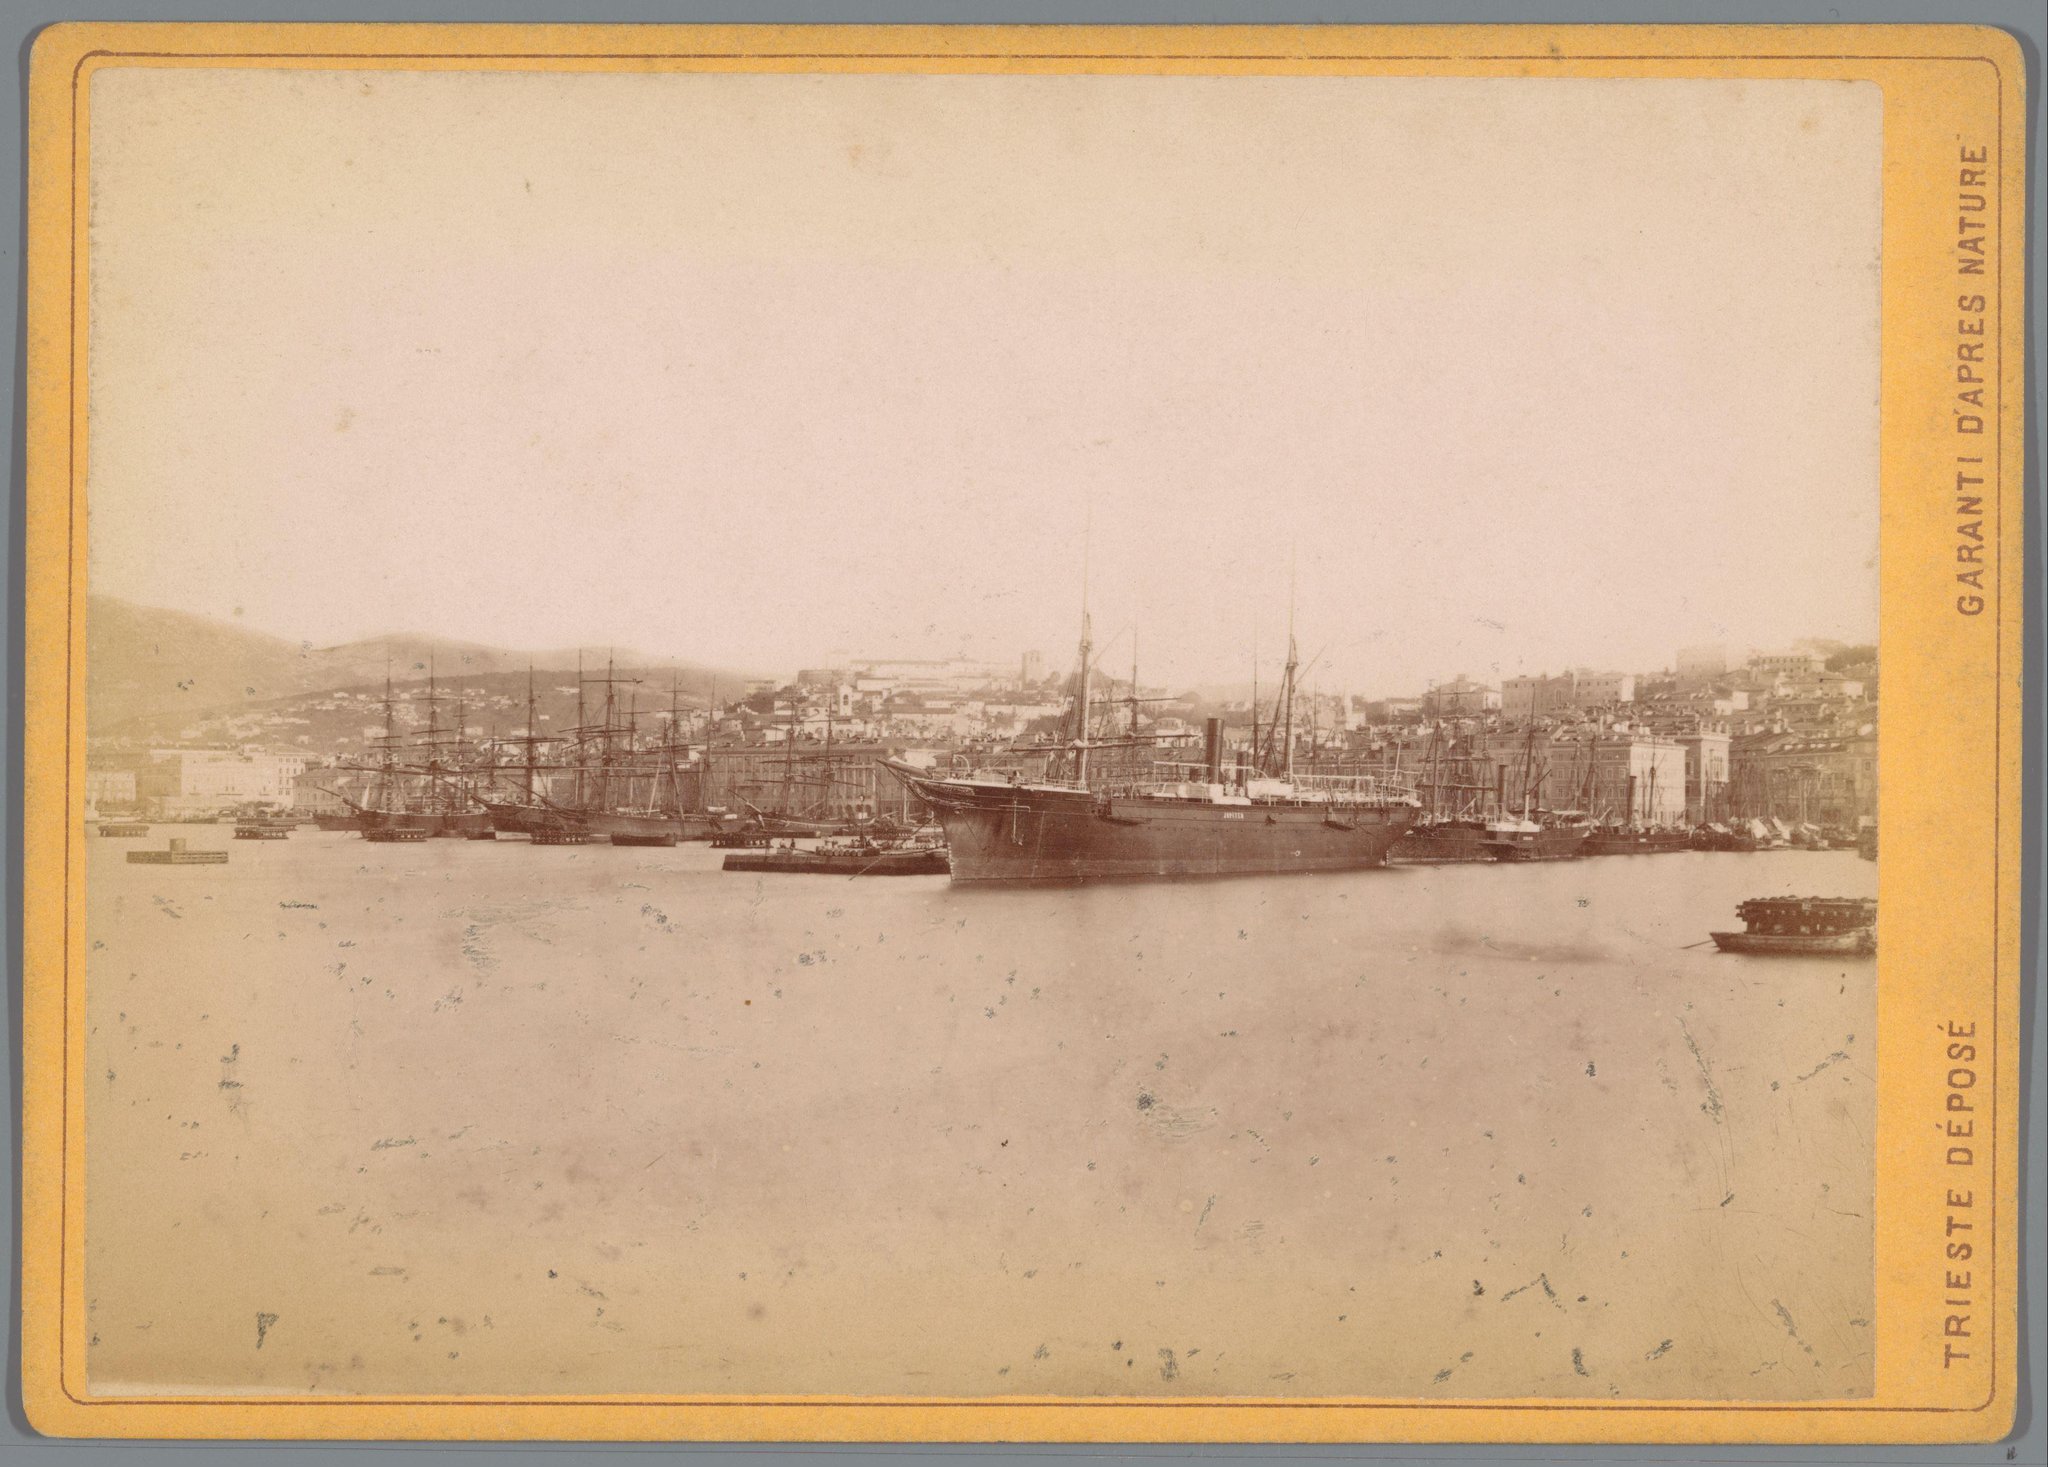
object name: cabinet photograph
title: Gezicht op de haven van vermoedelijk Triëst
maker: giuseppe wulz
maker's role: fotograaf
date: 1870-1890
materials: cardboard, photographic support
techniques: albumen print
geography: trieste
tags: harbour, ships (in general)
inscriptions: name: ‘Vosmaer’, inscription: ‘Trieste Déposé Garanti d'apres Nature’